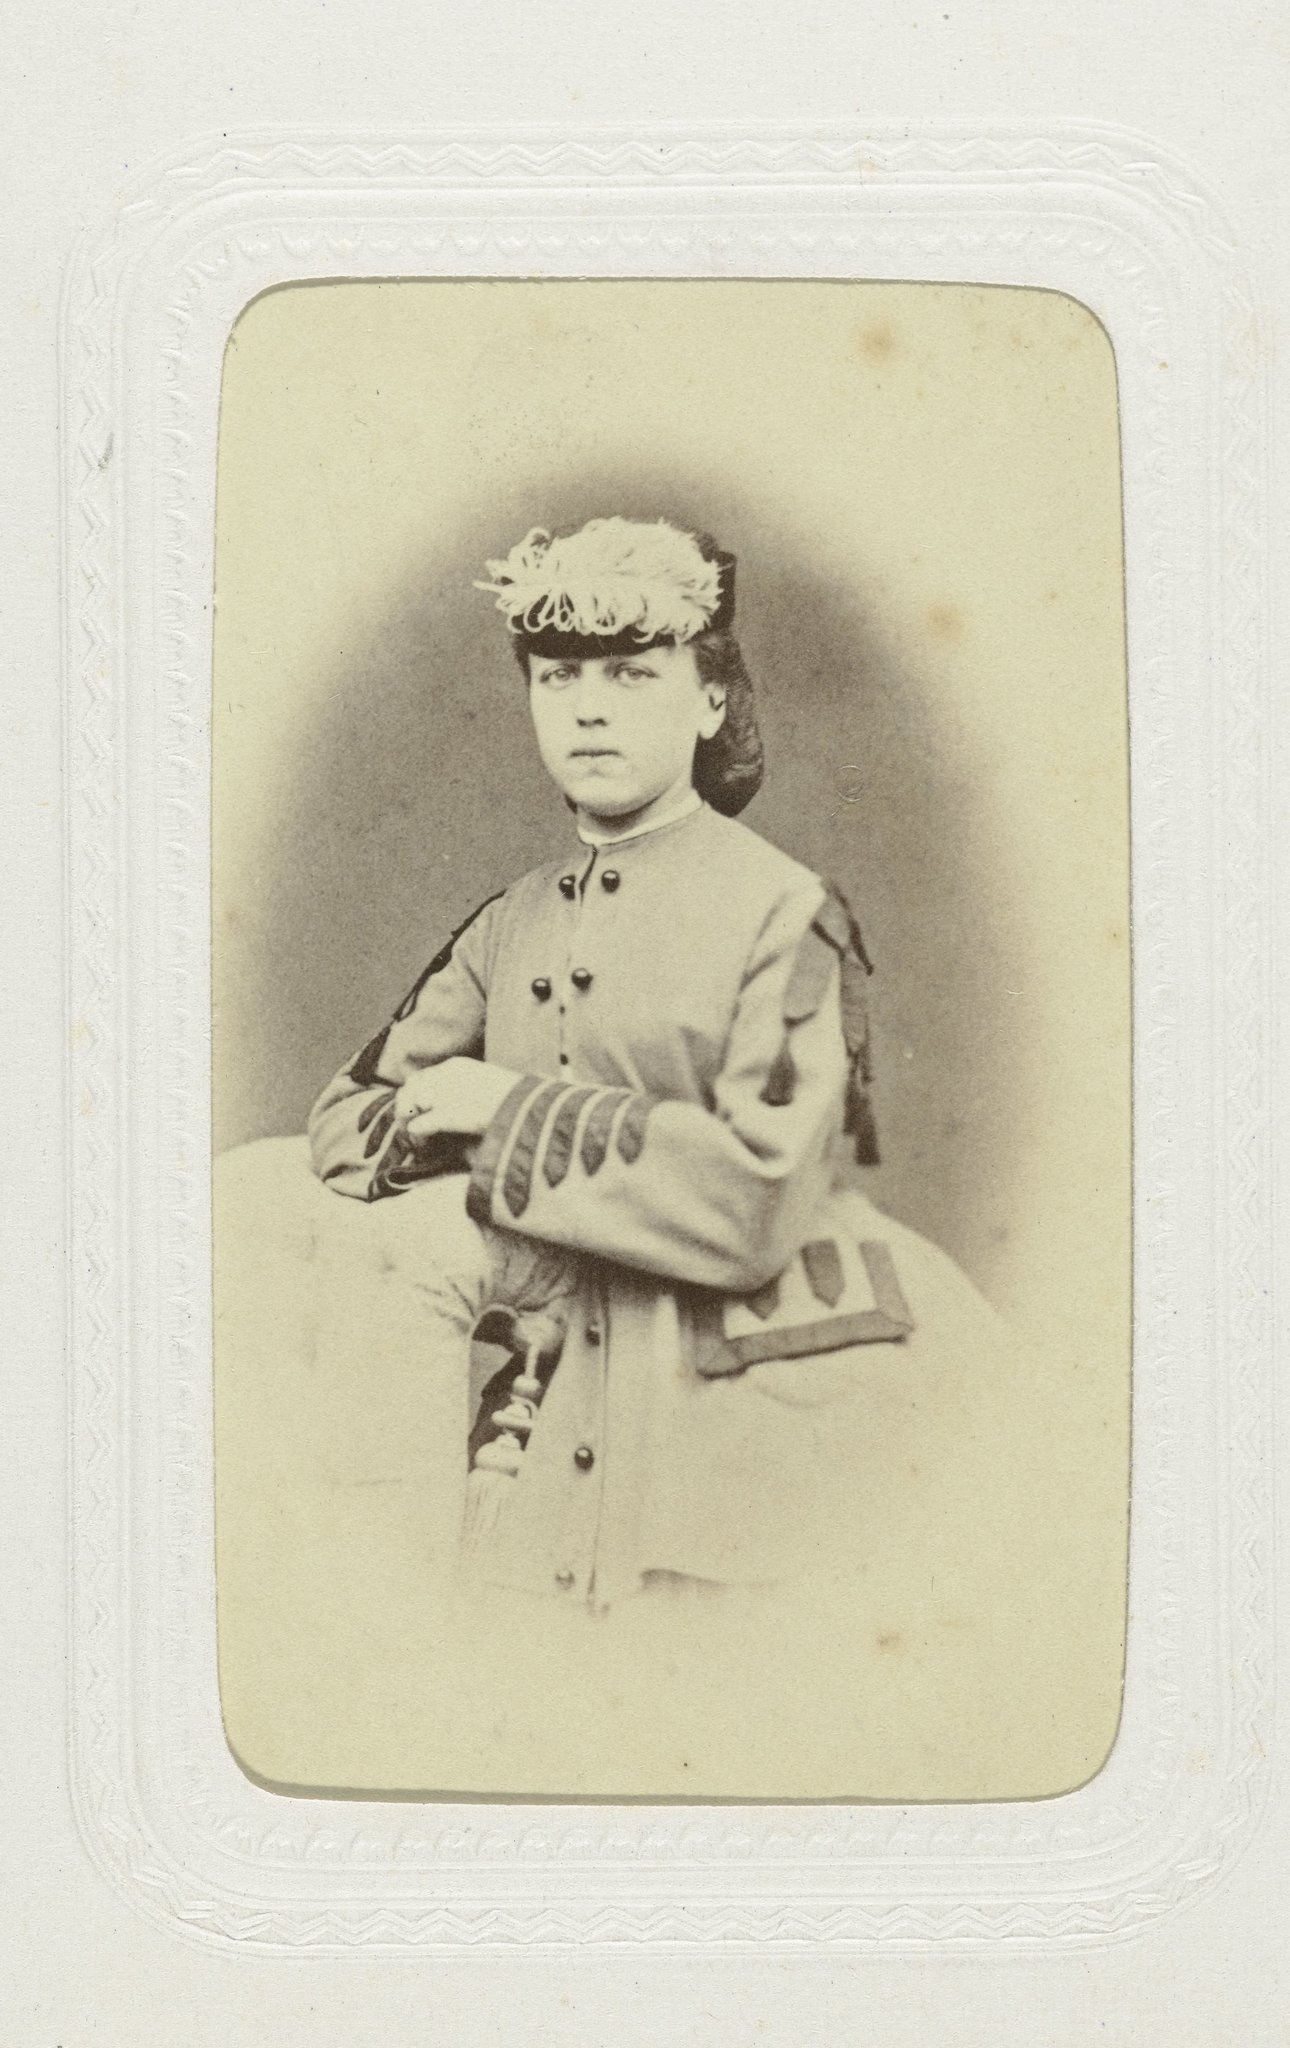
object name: carte de visite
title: Studioportret van een vrouw bij een stoel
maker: Anonymous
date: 1863-1866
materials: cardboard, paper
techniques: albumen print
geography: amsterdam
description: De vrouw draagt een lange jas met knopen met een hoedje op het hoofd.